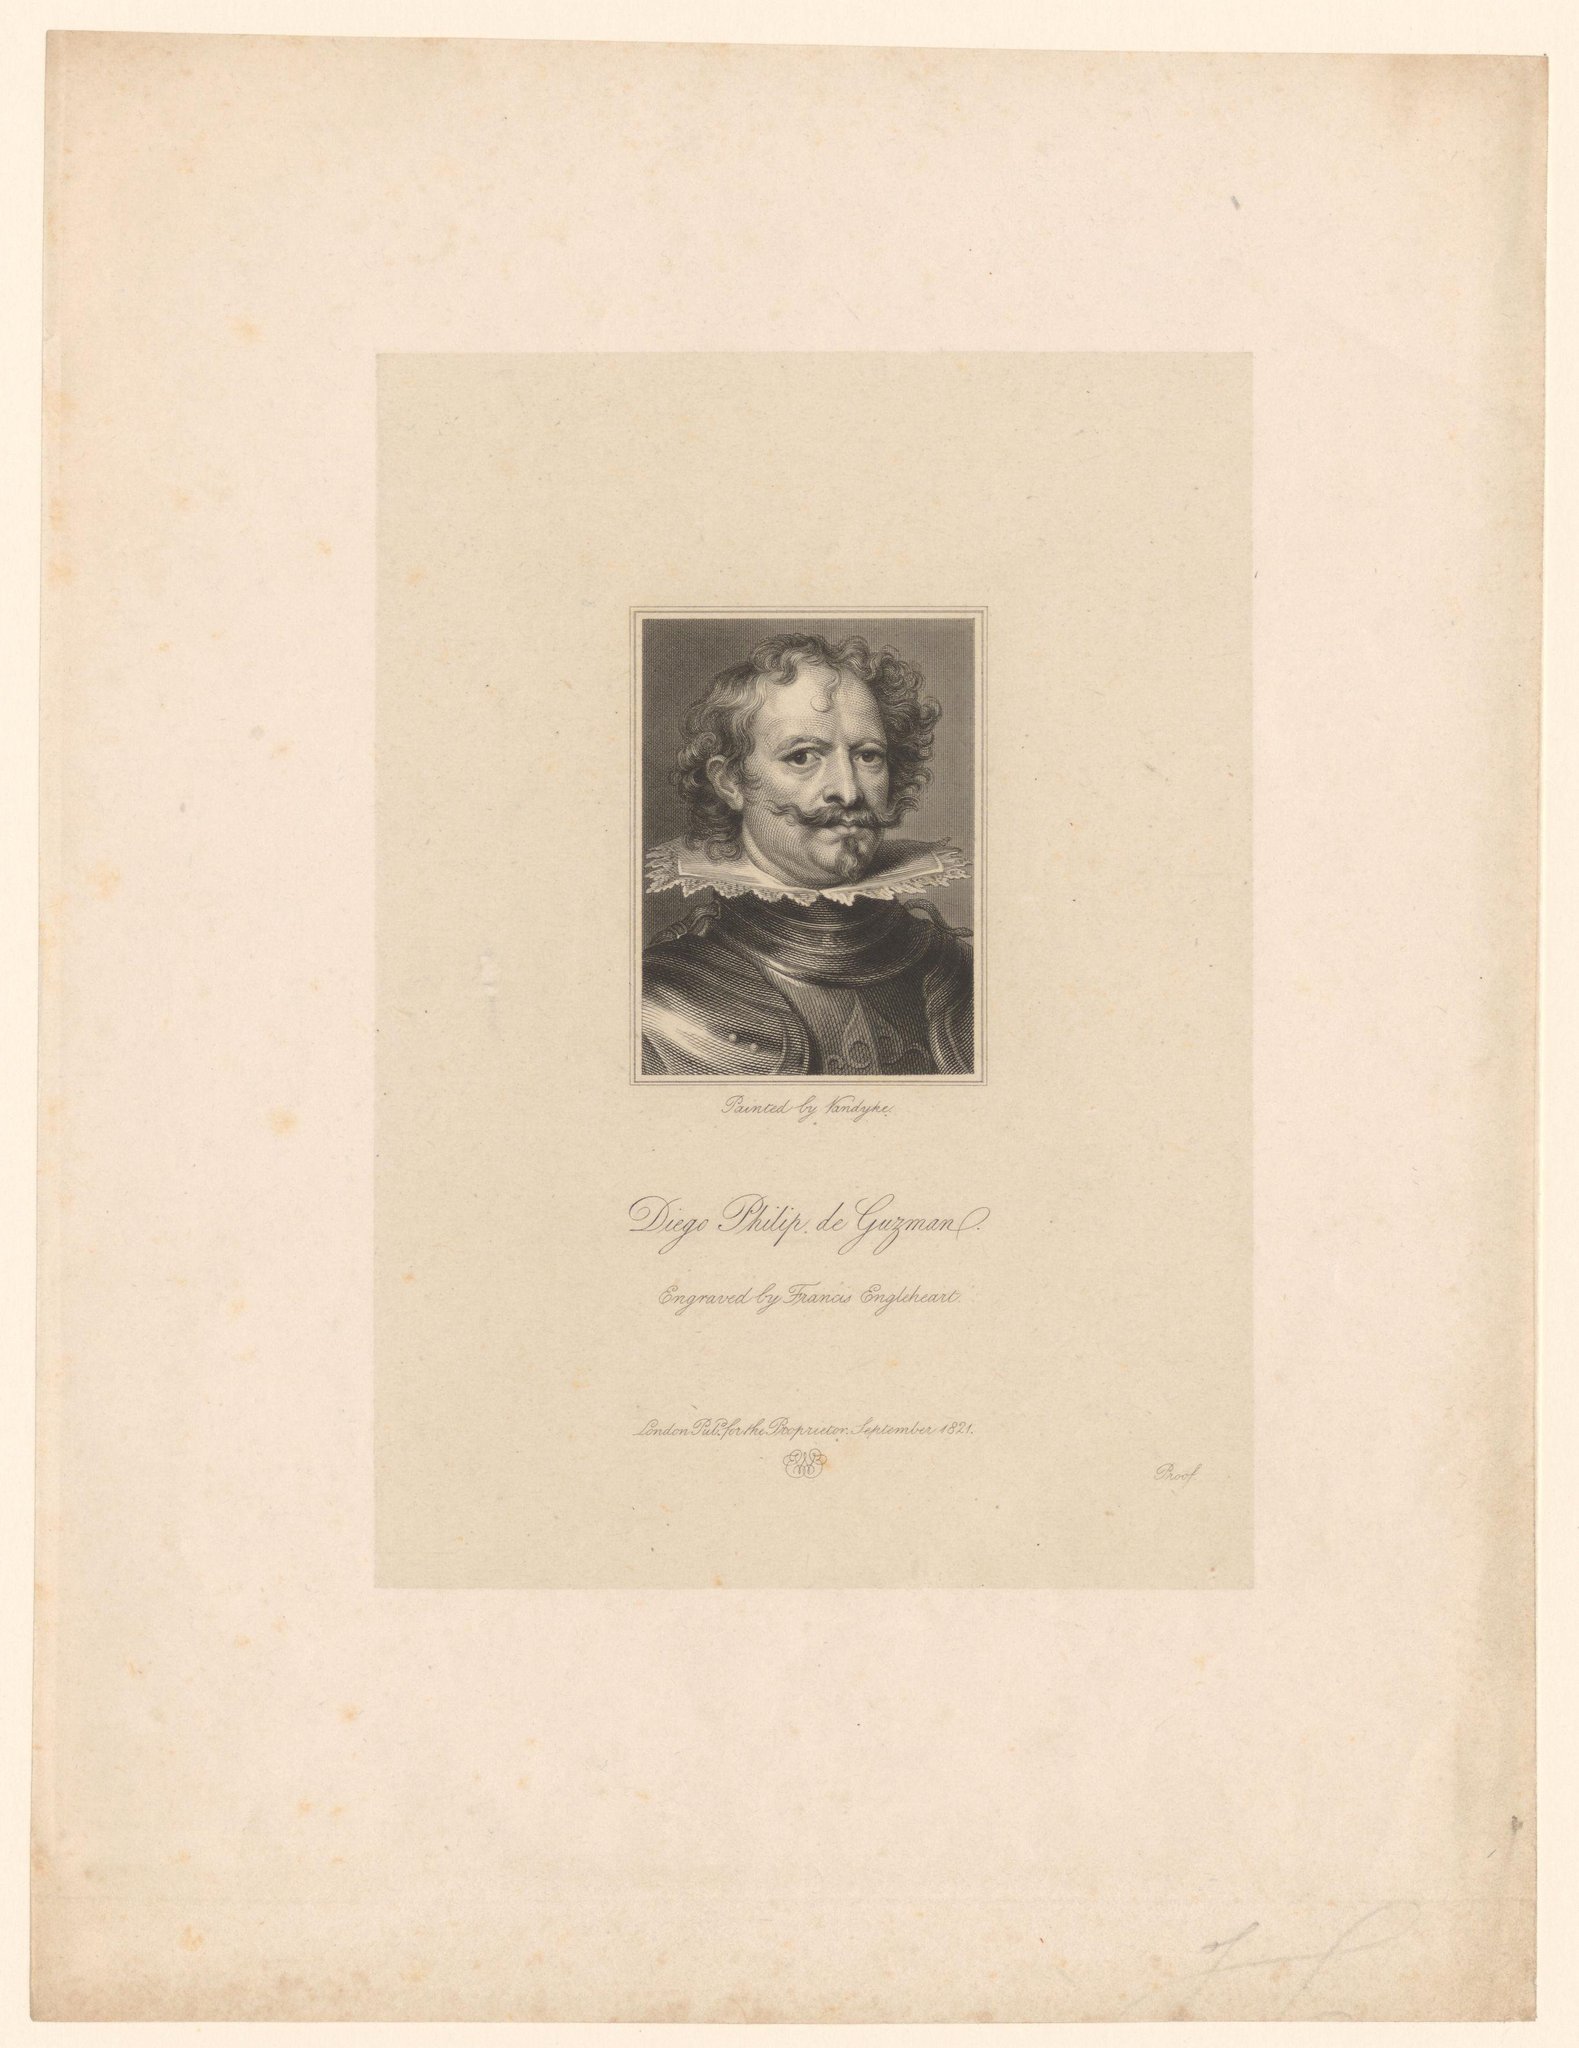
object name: book illustration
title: Portret van Diego Felipez de Guzmán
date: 1809-1821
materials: paper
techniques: engraving, etching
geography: london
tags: commander-in-chief, general, marshal, historical persons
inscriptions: collector's mark: Lugt 2228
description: Prent gebruikt in: Walmsley, Edward. Physiognomical Portraits: One Hundred Distinguished Characters (...). Londen: John Major et al., 1822.